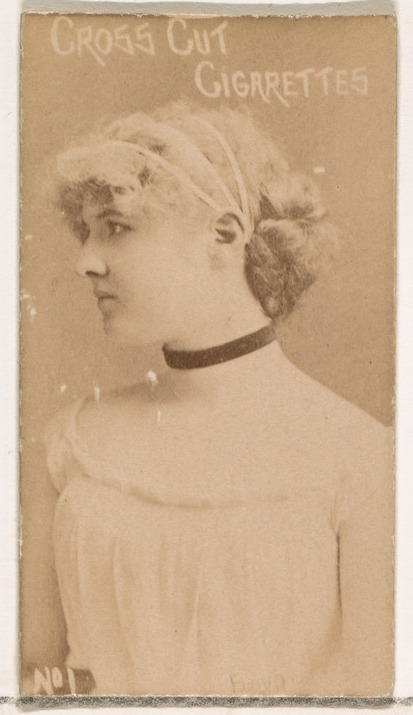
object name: print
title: Card Number 1, from the Actors and Actresses series (N145-1) issued by Duke Sons & Co. to promote Cross Cut Cigarettes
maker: w. duke, sons & co.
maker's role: publisher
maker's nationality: american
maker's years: 1870-1920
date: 1880-1889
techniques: albumen silver print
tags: women,actresses